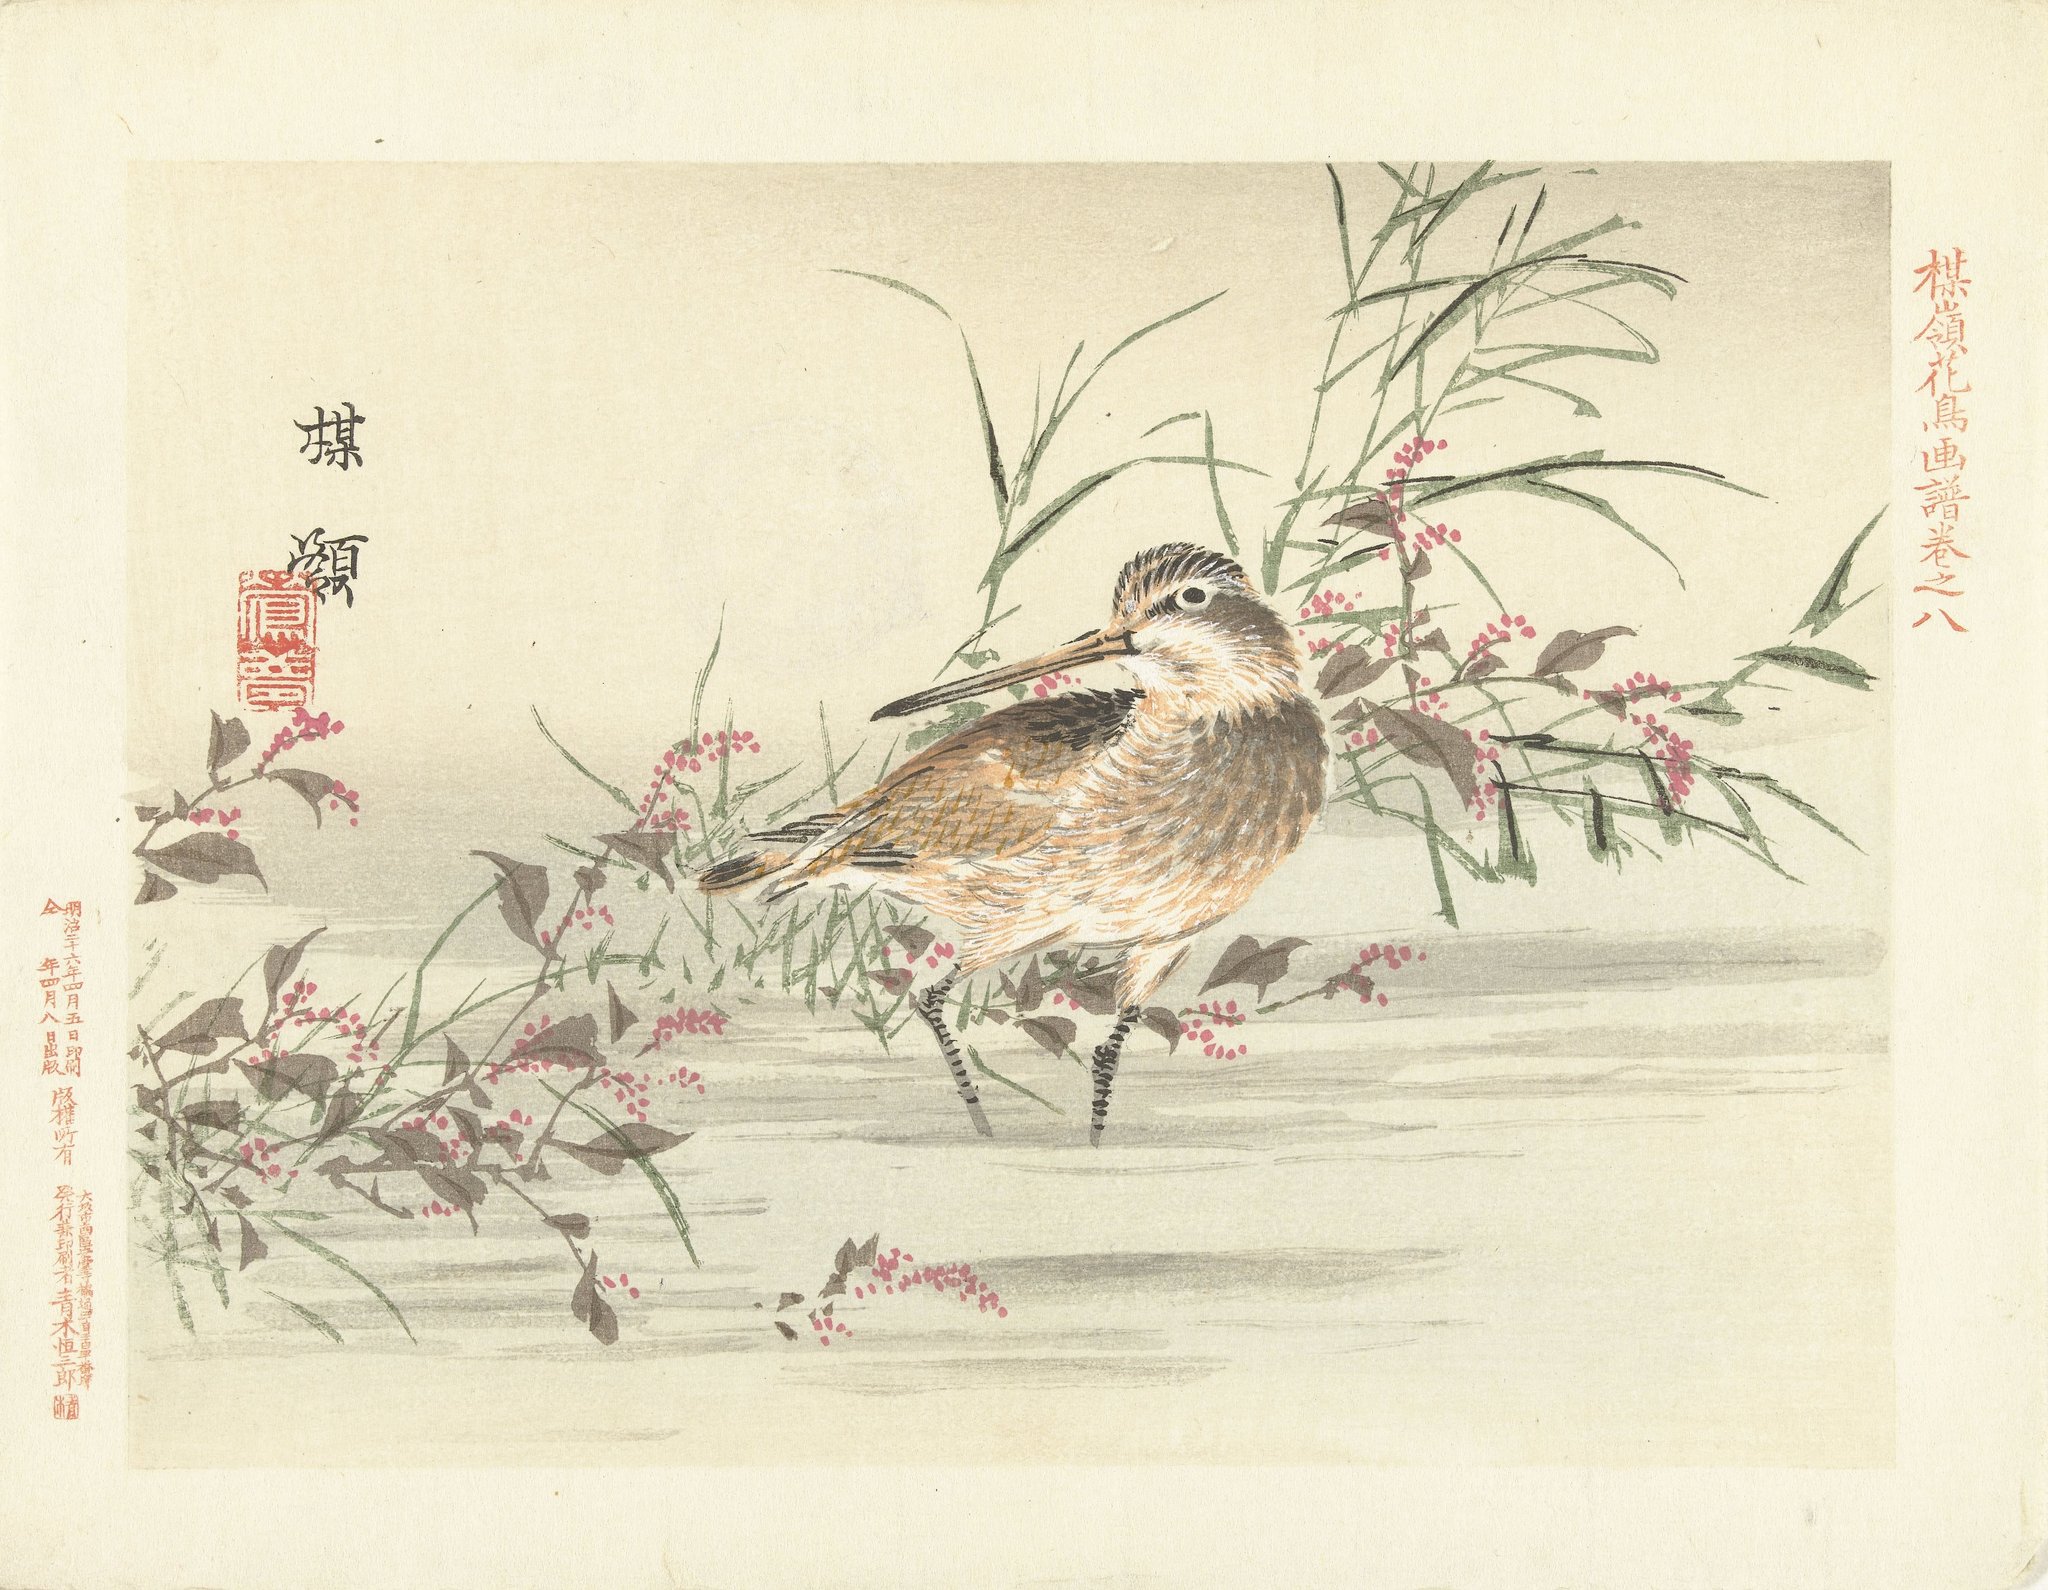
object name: print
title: Bairei`s bloemen- en vogelschetsen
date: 1804-1893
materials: paper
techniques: woodcut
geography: japan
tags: plants; vegetation, shore-birds and wading-birds: snipe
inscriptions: collector's mark: ‘Rijksschool voor kunstnijverheid’ Lugt 3937, collector's mark: Lugt 2228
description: Vogel met lange snavel, in ondiep water.